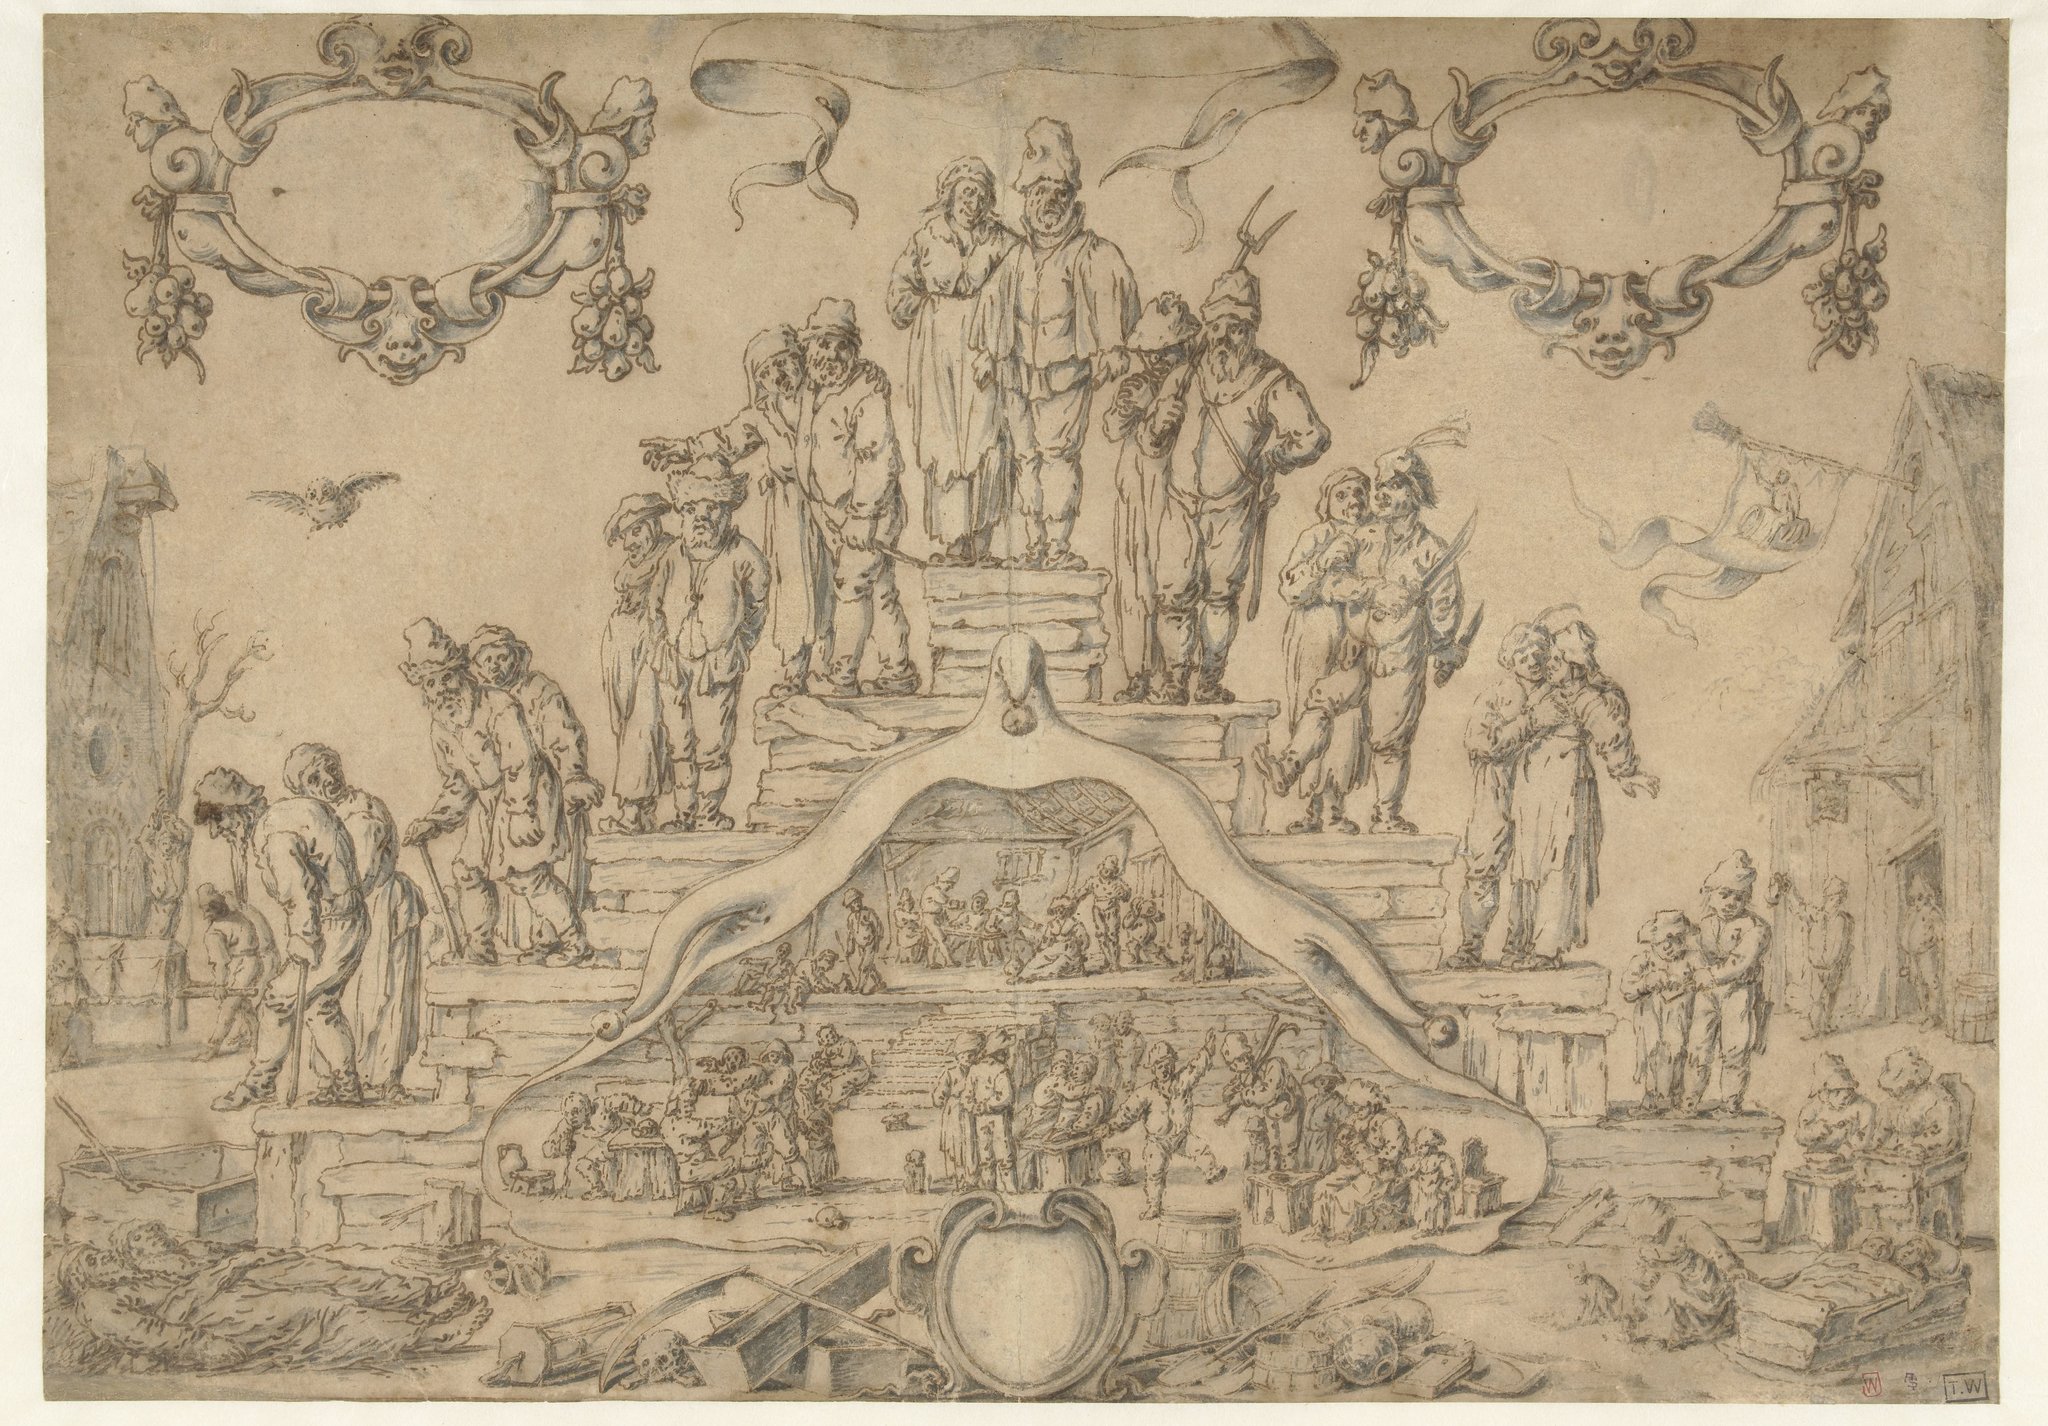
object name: drawing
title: Trap des Ouderdoms met boeren en boerinnen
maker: pieter nolpe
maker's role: draughtsman, print maker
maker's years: 1613-1653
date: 1623-1652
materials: ink, paper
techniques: brush, pen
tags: the ages of man represented by a staircase (10), inn, coffee-house, public house, etc., farmers, farmers - aa - female farmer, farmer's wife, fool's cap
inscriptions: inscription: ‘A. Both ; Les ages de la Vie / par André Both en merk T. de Wyzewa’, collector's mark